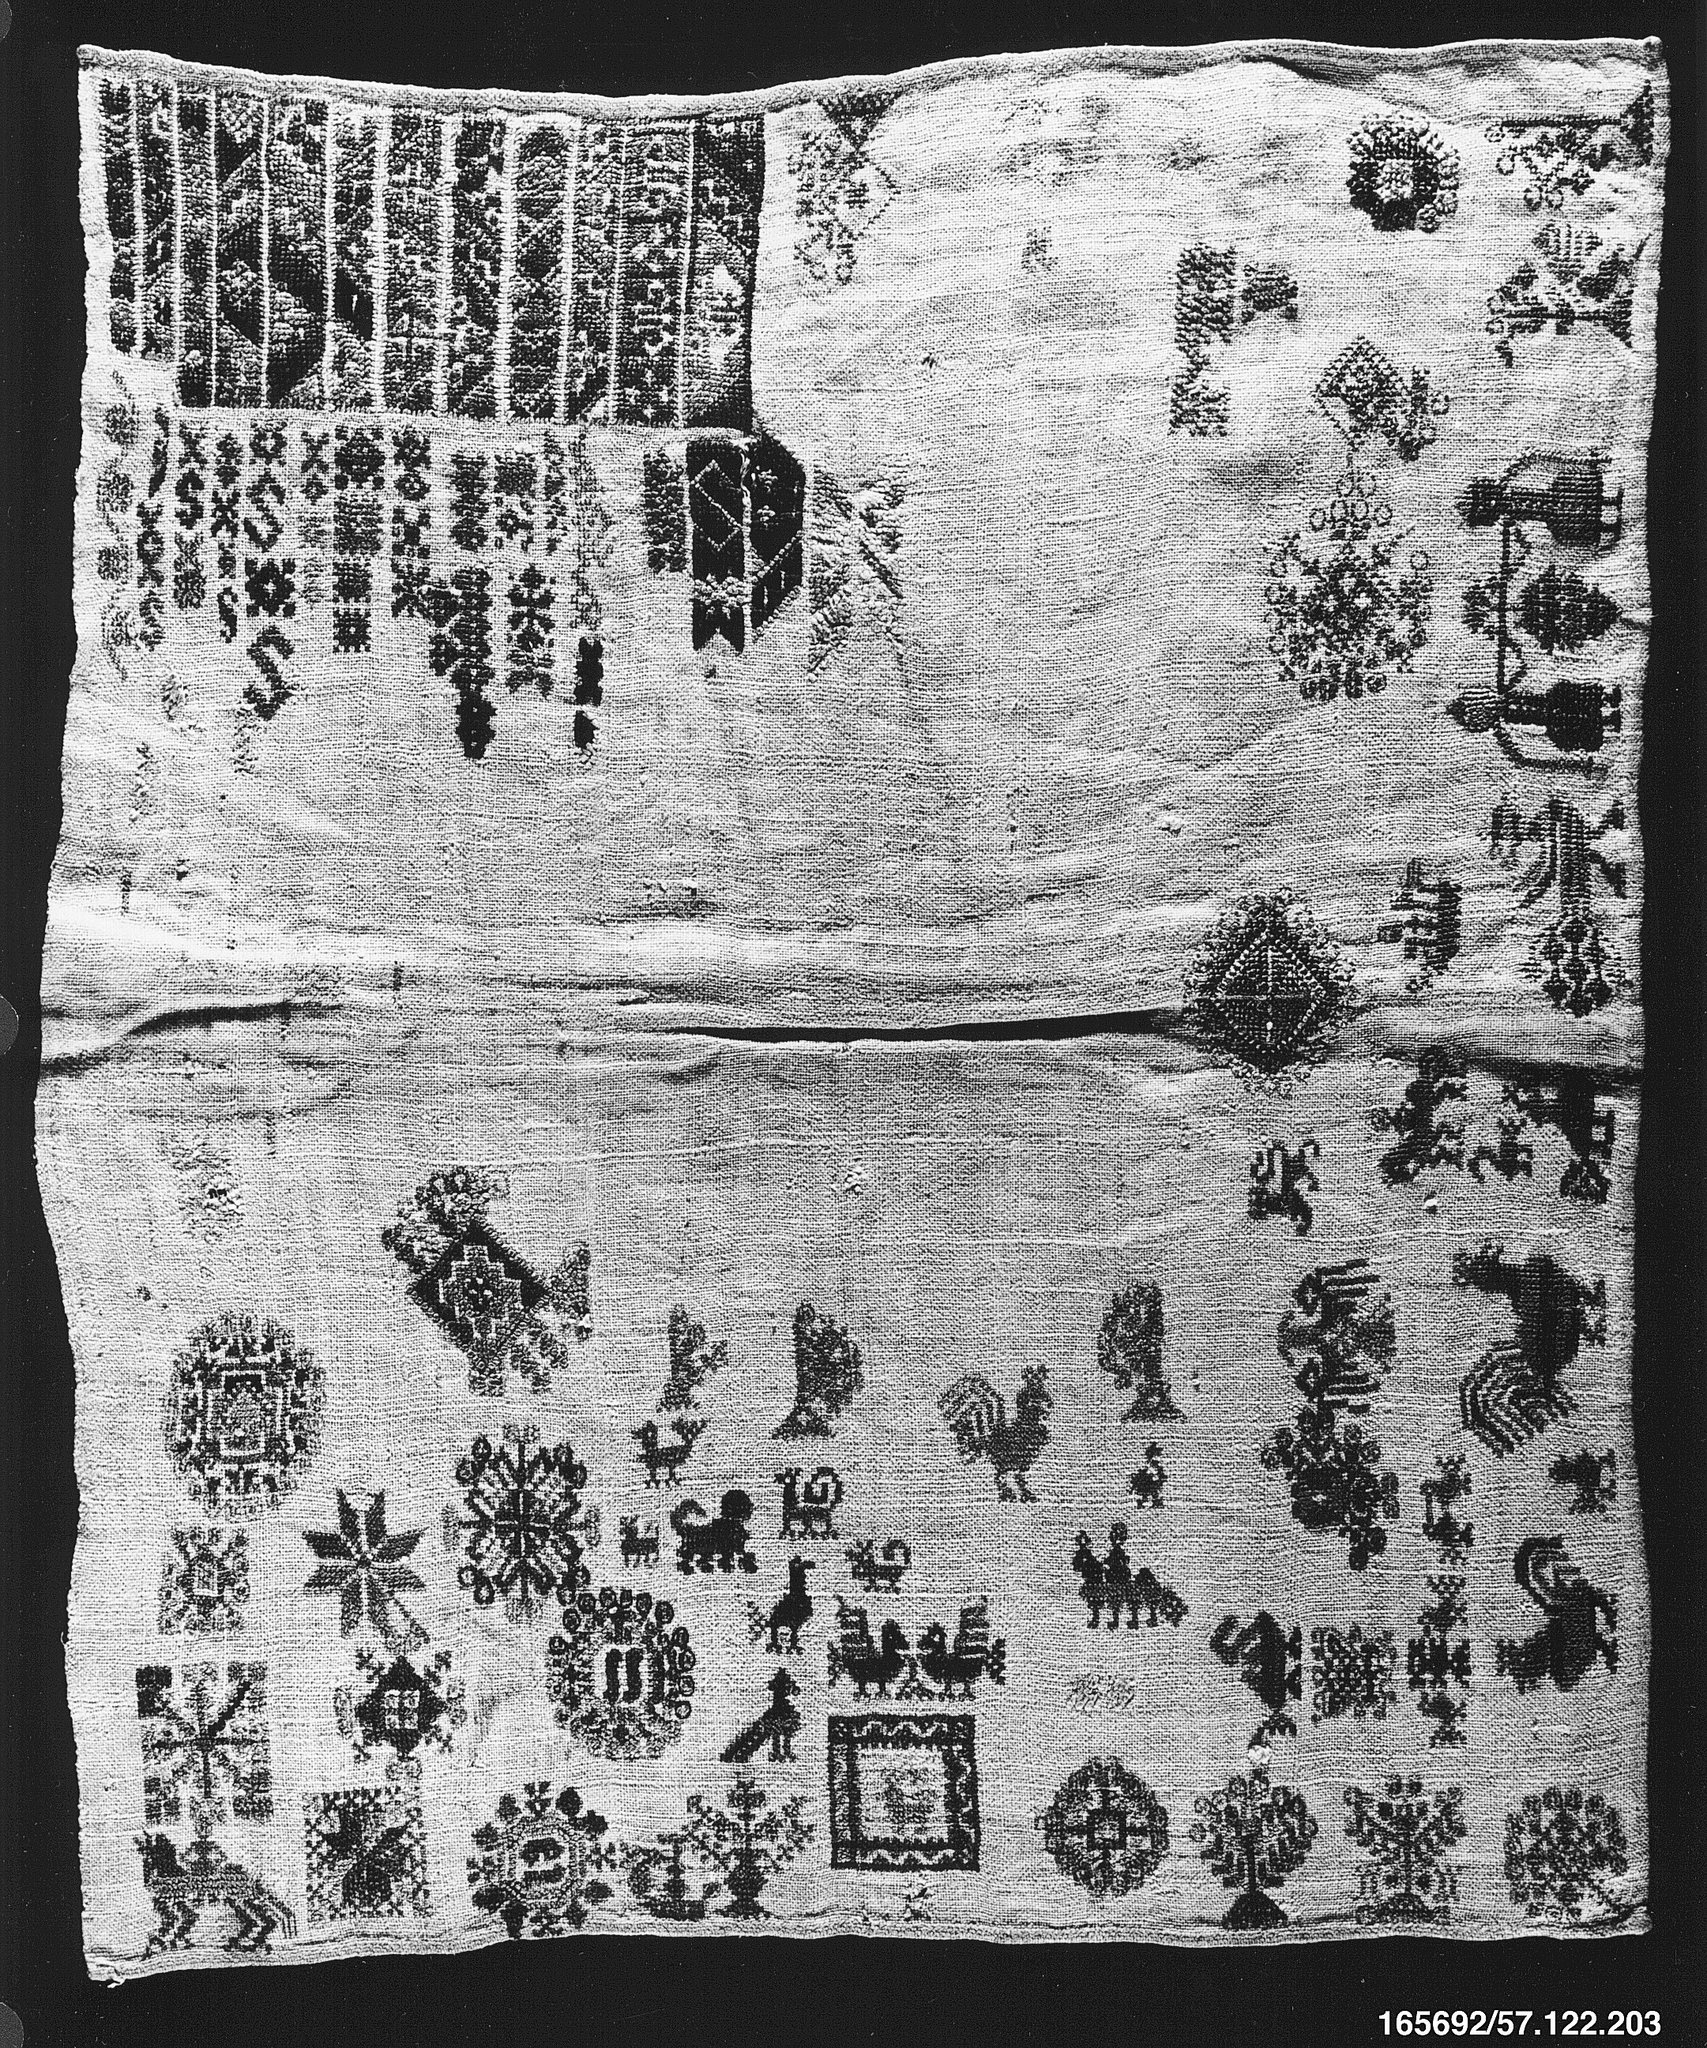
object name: sampler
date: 1701-1800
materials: linen, silk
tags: animals,birds,flowers